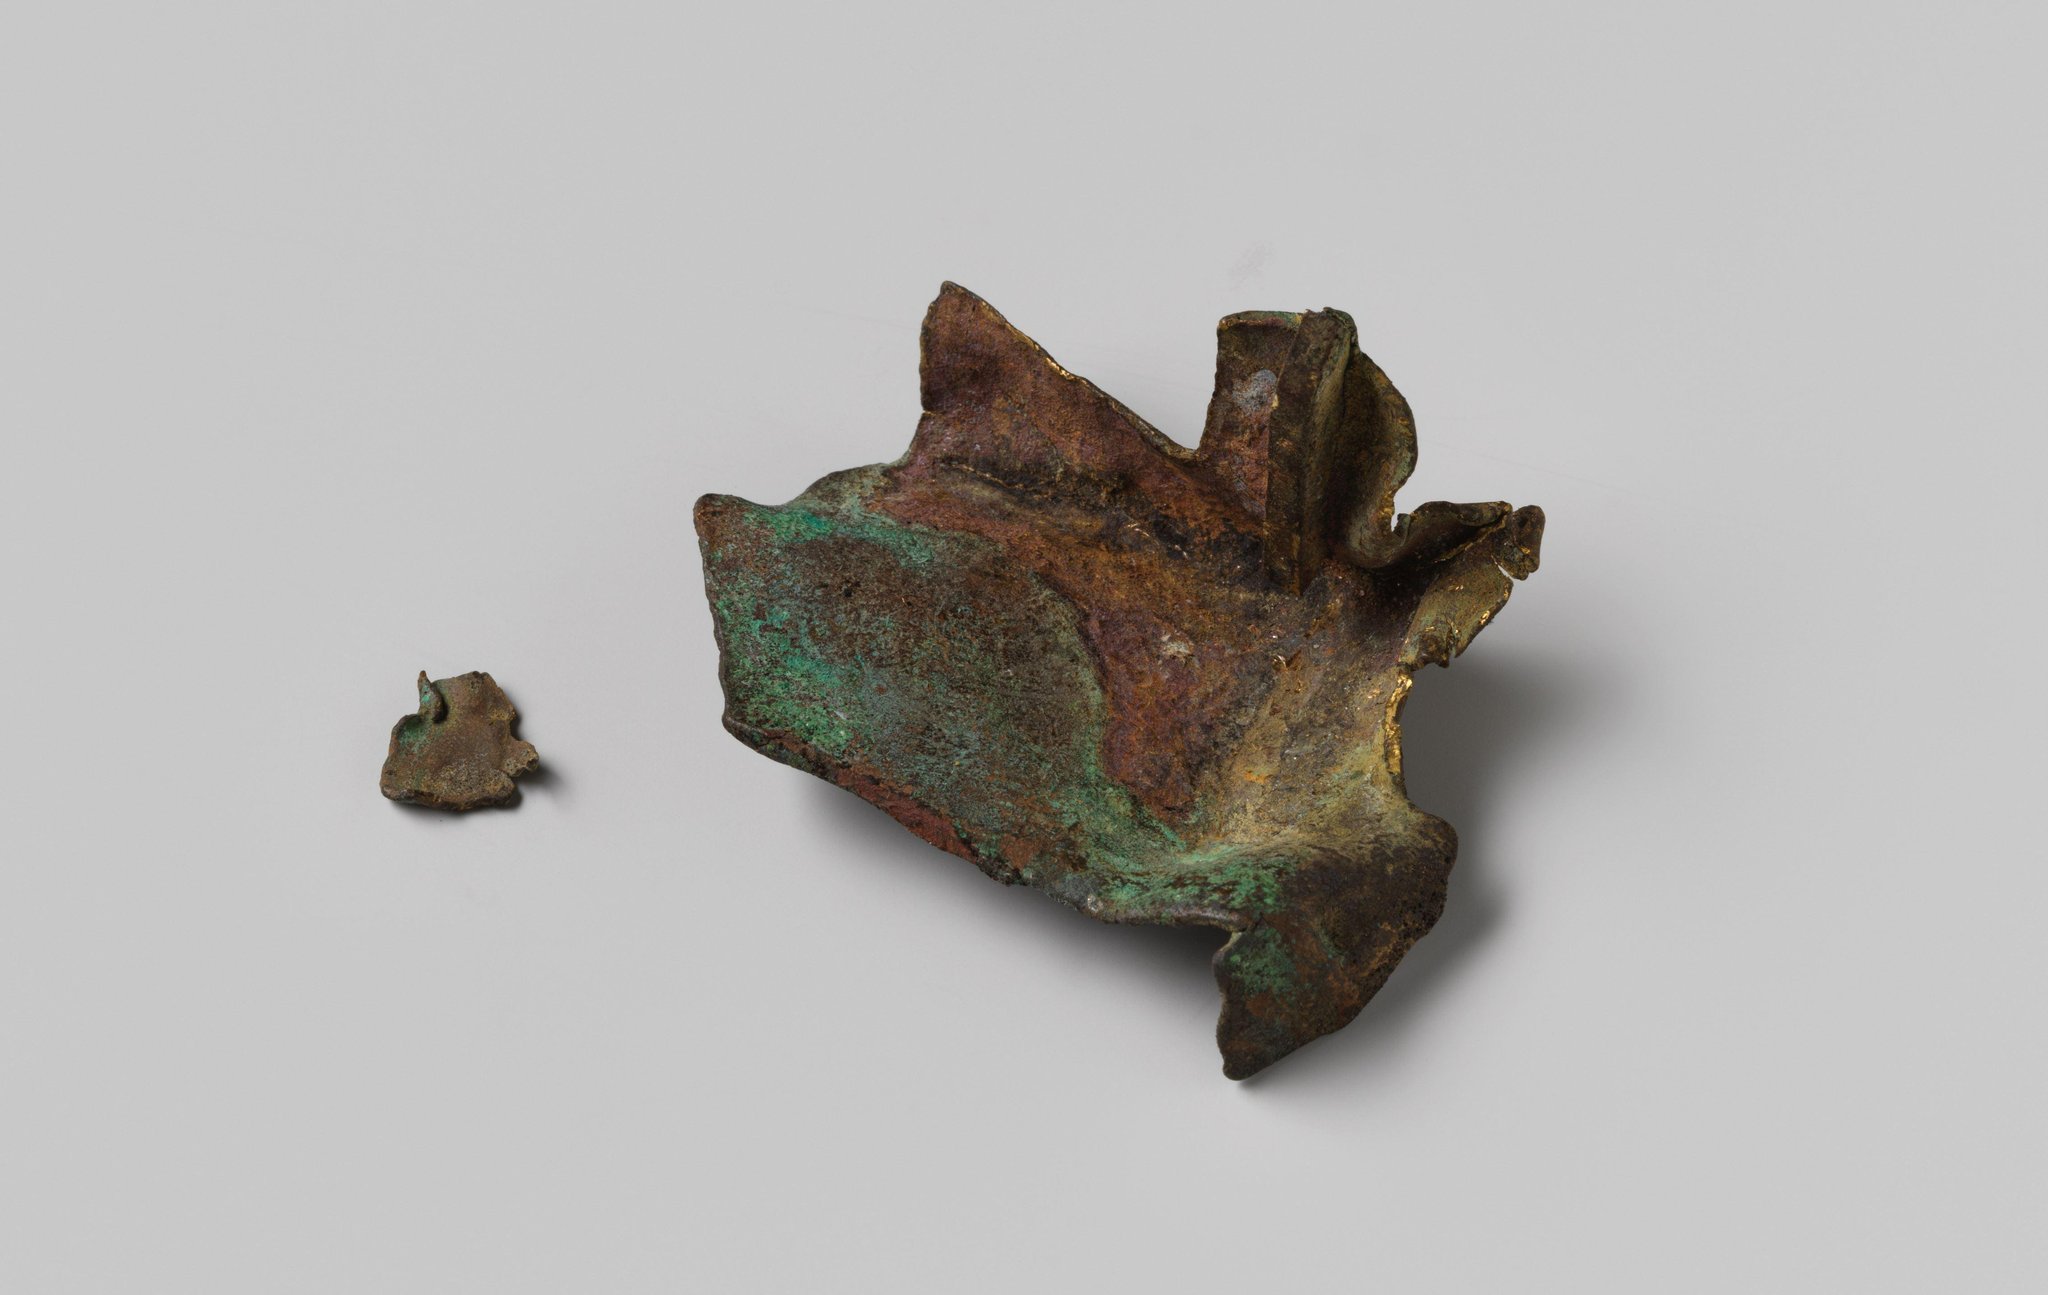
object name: fragment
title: Fragment van koper uit het wrak van de Oost-Indiëvaarder Hollandia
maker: Anonymous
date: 1700-1743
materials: copper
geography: netherlands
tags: verenigde oostindische compagnie, hollandia (schip), annet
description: Varied parts or fragments, unidentified and miscellaneous parts or fragments; fragm.